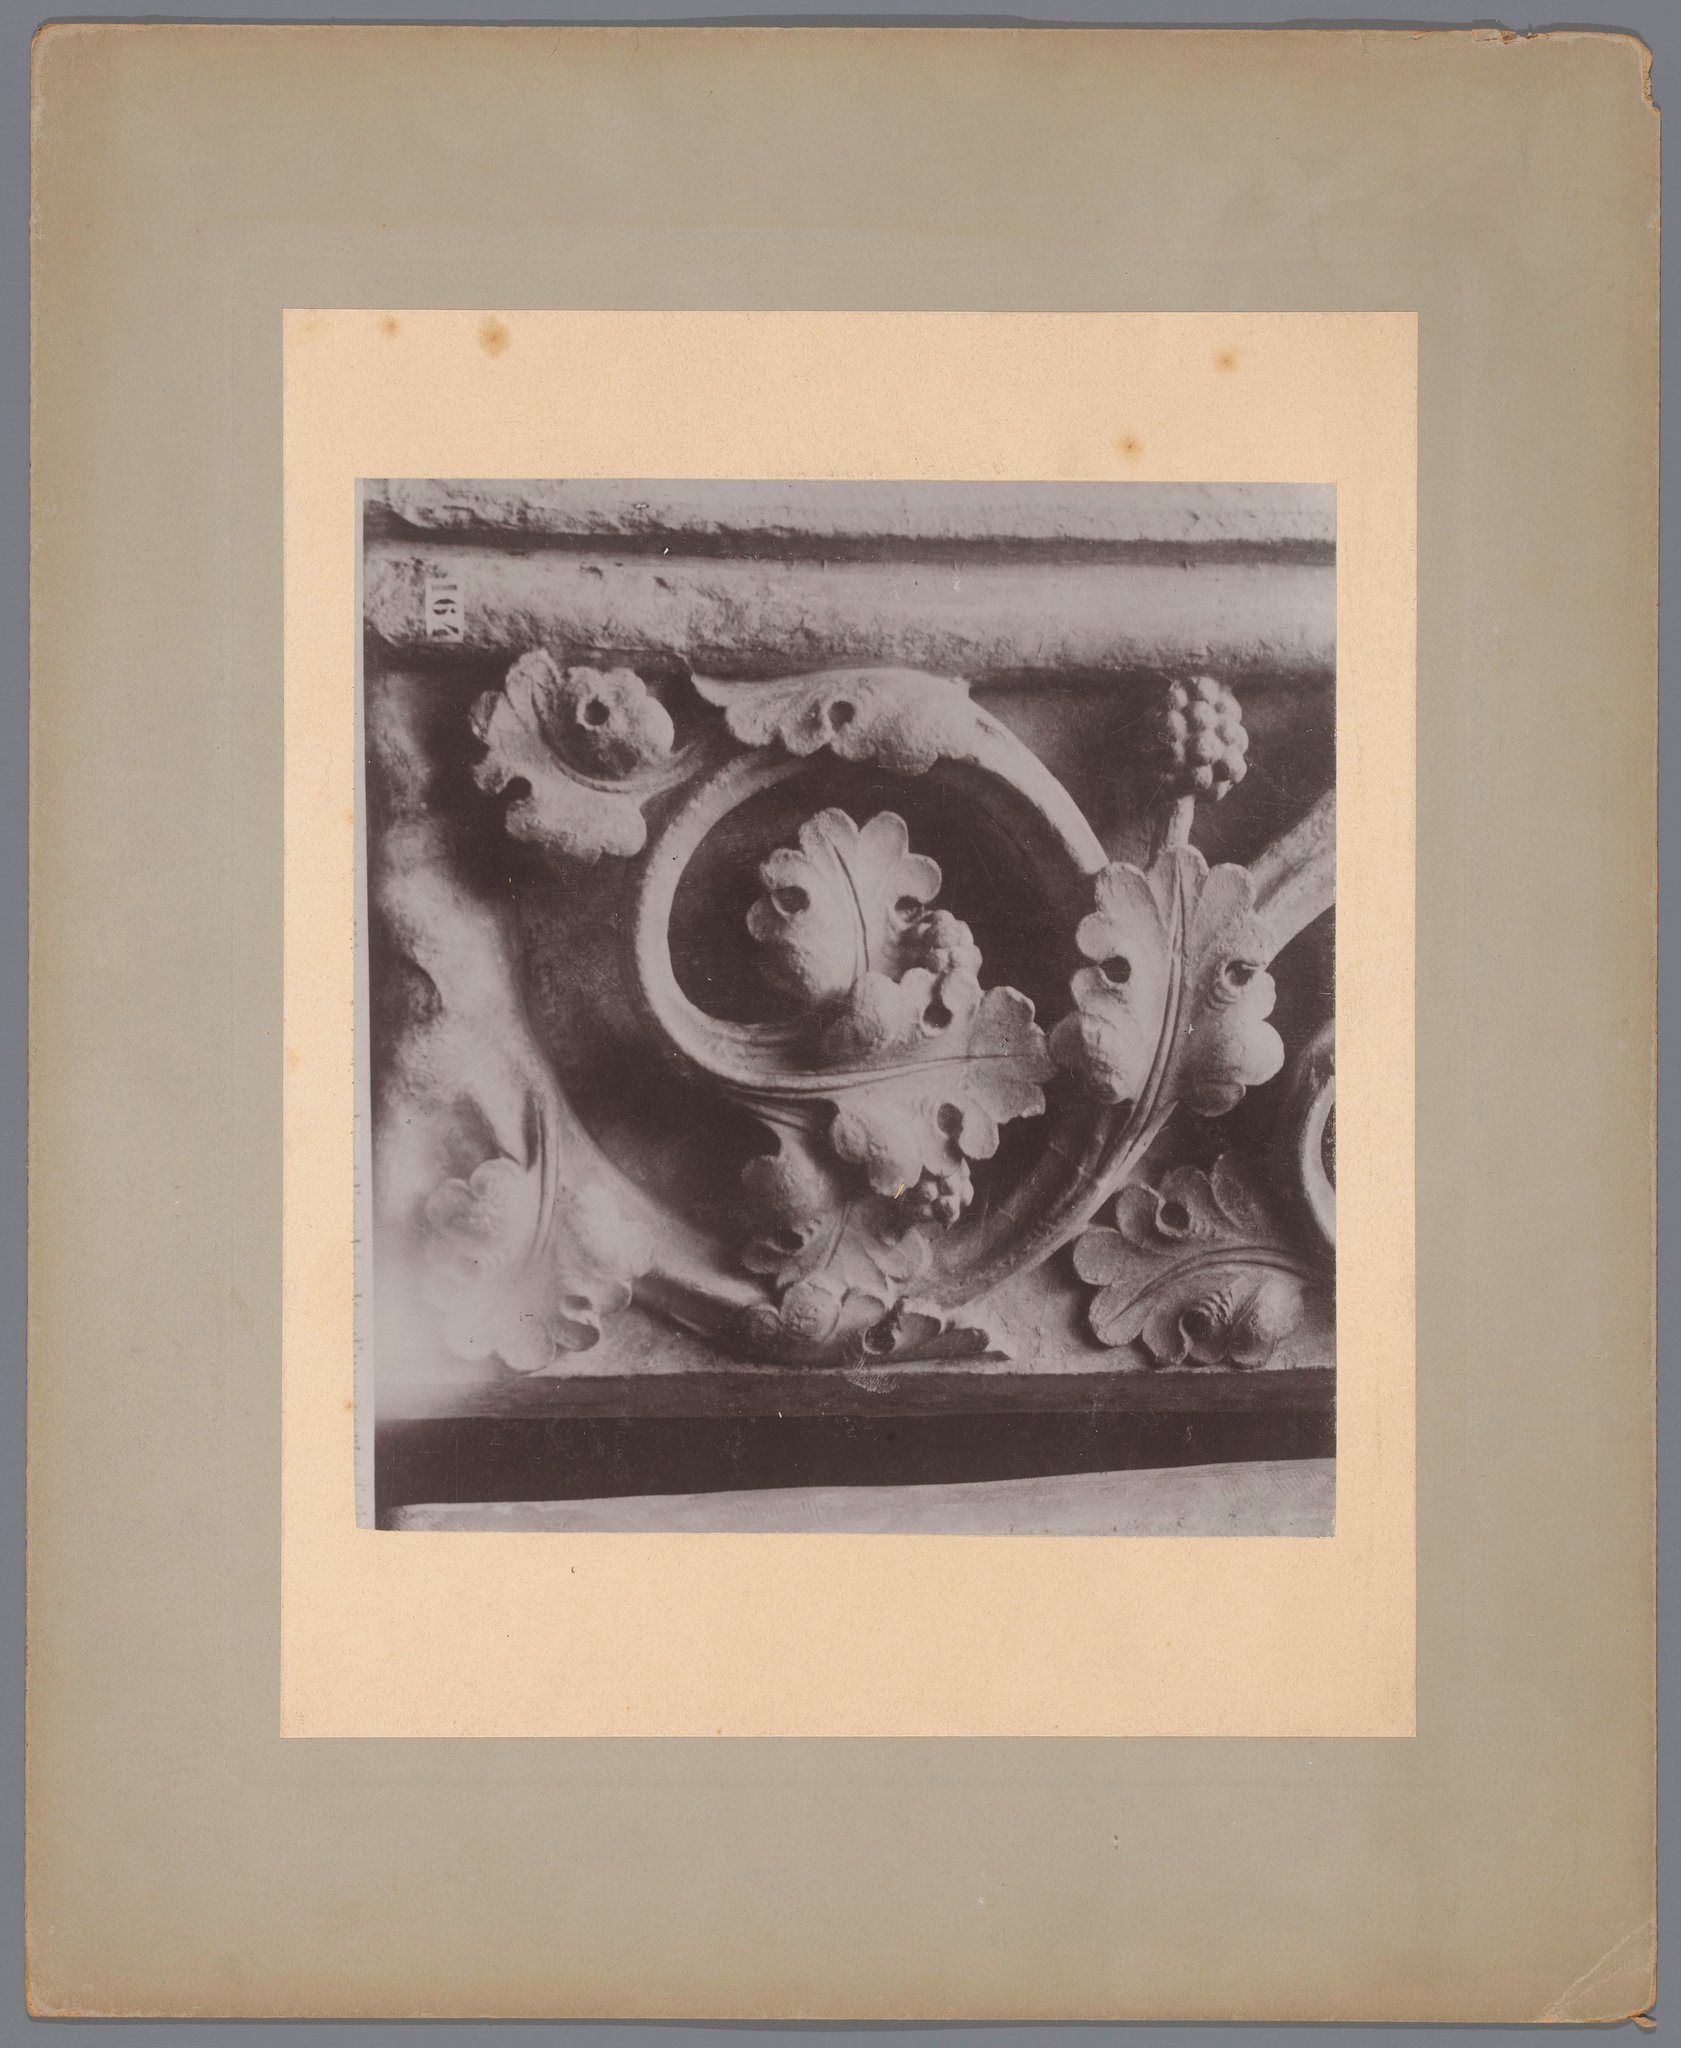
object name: photograph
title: Afgietsel van een detail van een archivolt versierd met rankwerk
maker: Anonymous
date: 1880-1940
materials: paper, cardboard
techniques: collodion silver print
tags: arch, archivolt ~ architecture, trees: oak (+ leaves, putting forth leaves)